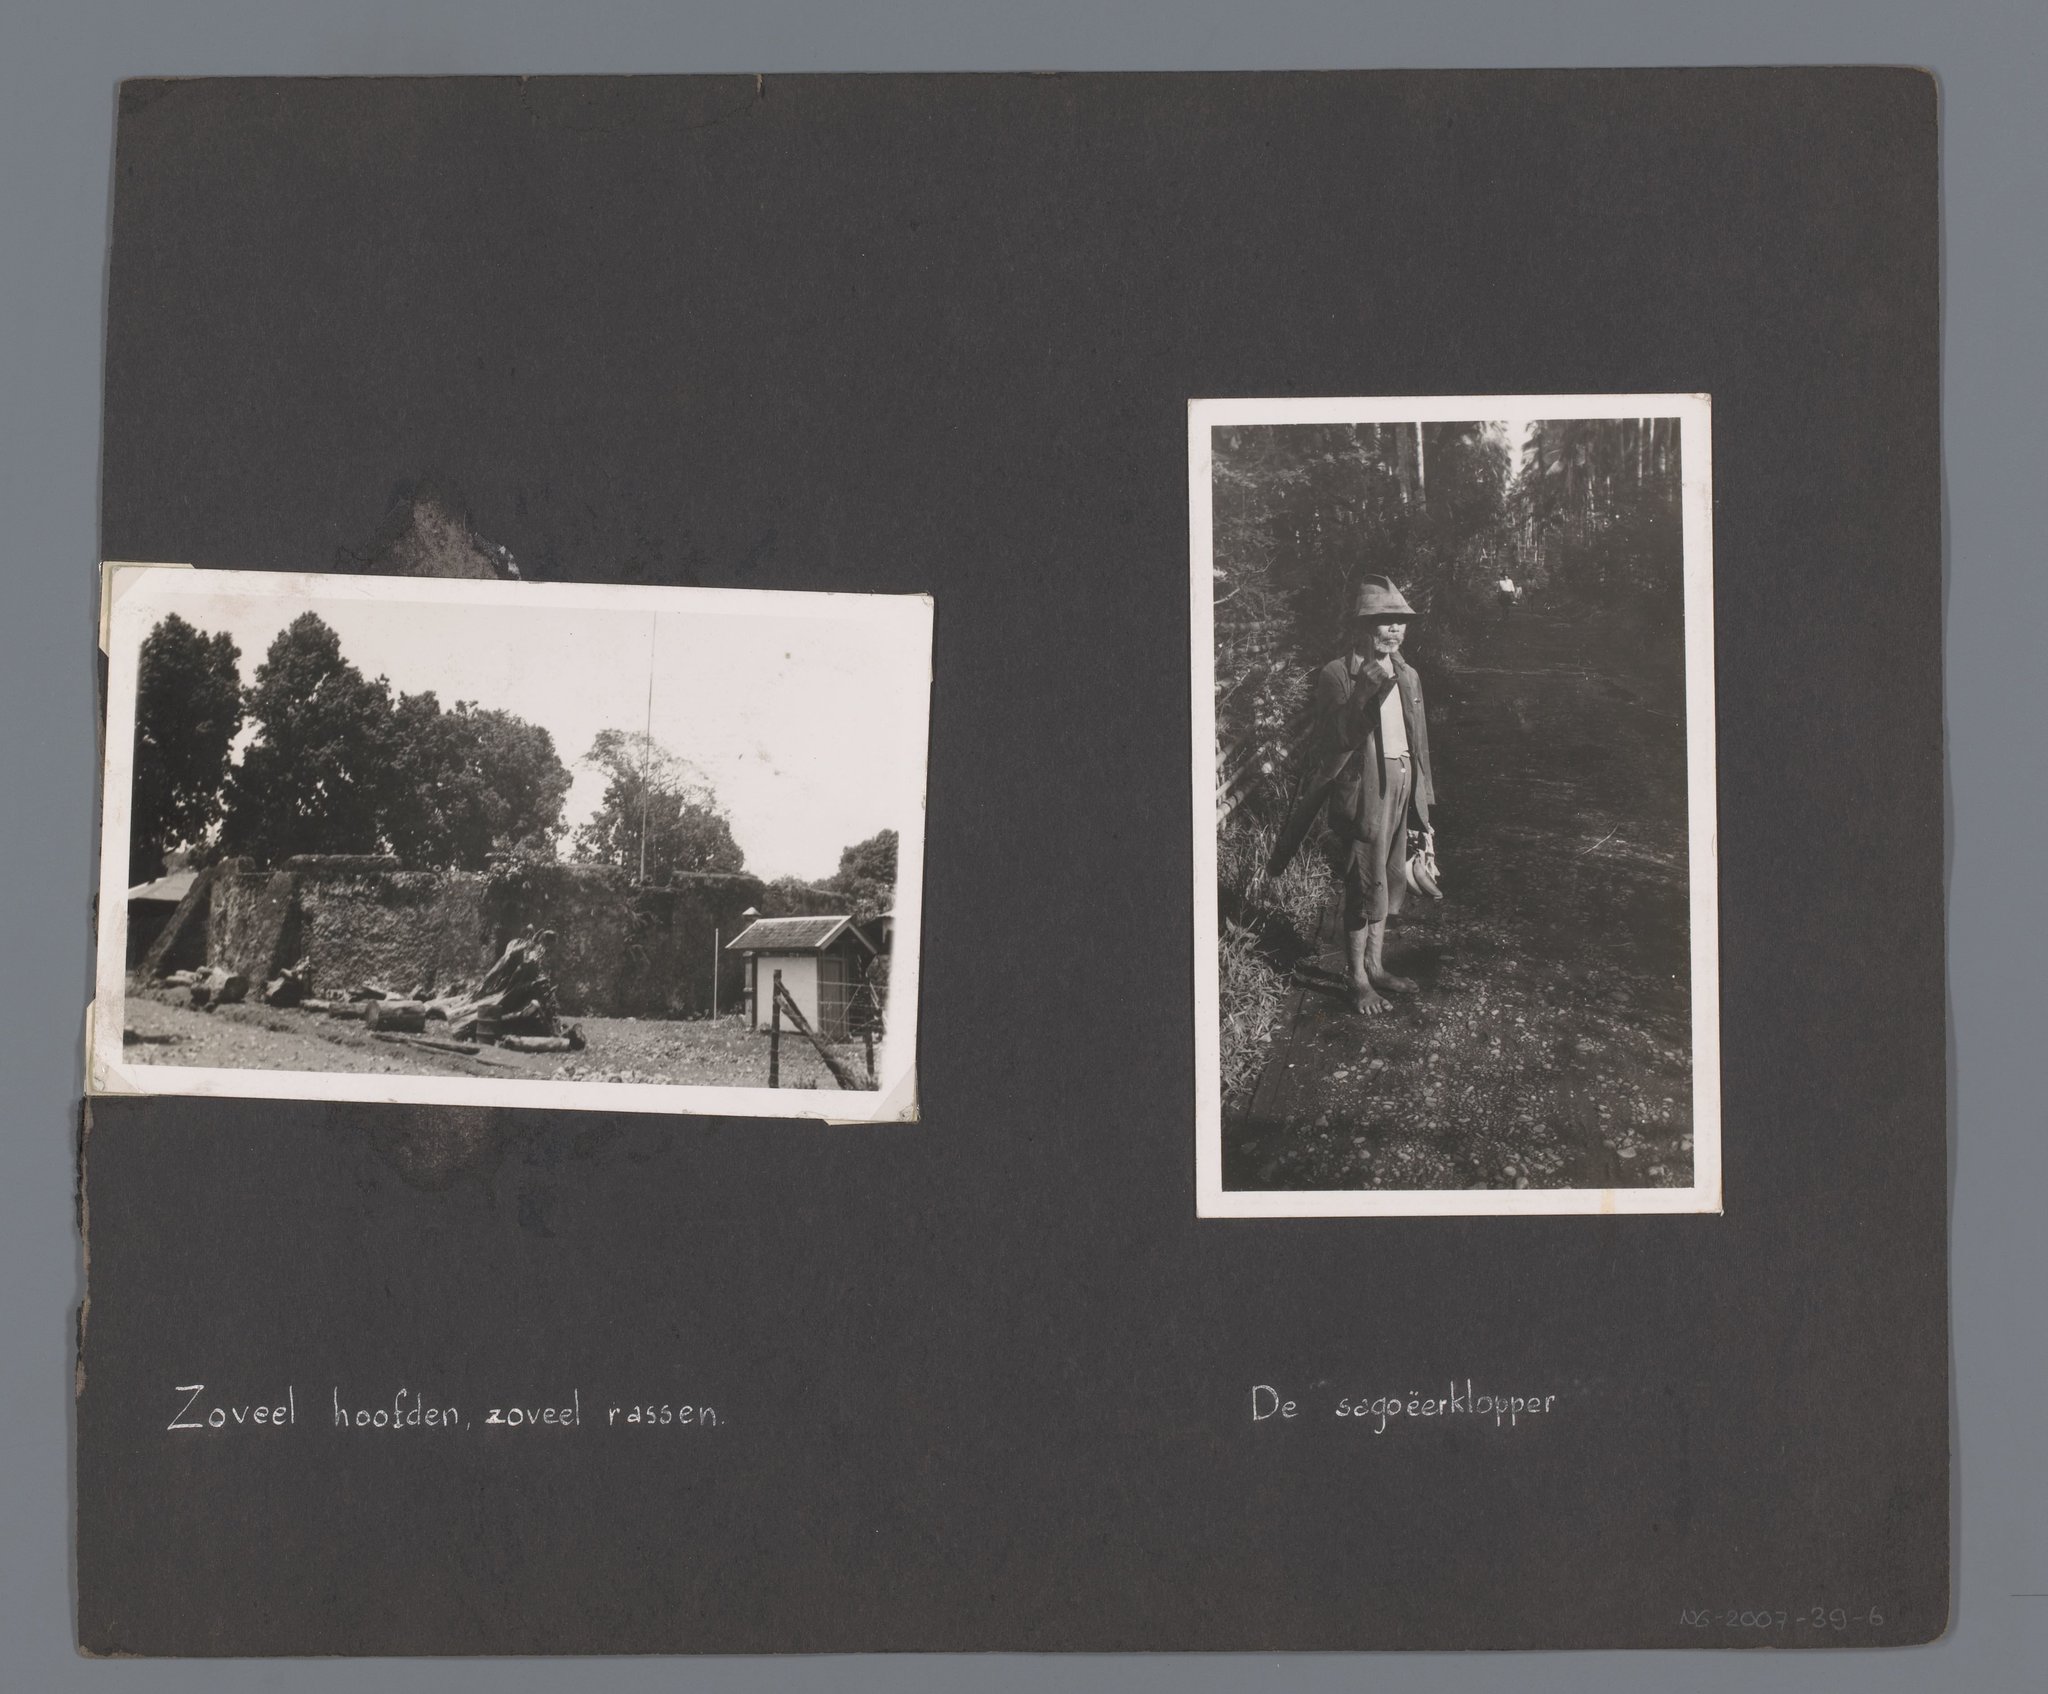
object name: photograph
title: Zoveel hoofden, zoveel rassen / De Sagoëerklopper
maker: Anonymous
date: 1930-1939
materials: paper, photographic support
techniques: gelatin silver print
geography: celebes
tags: fraters van tilburg, amurang, celebes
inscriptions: annotation: ‘Zoveel hoofden, zoveel rassen // De sagoëerklopper’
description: Zwart albumblad met twee foto's van een oud fort (vermoedelijk in Amurang op Celebes) en een sagoklopper. De foto die oorspronkelijk op deze plaats zat (onderschrift: Zoveel hoofden, zoveel rassen), ontbreekt. Onderdeel van het losbladig fotoalbum over de Fraters van Tilburg op Celebes en Sumatra.